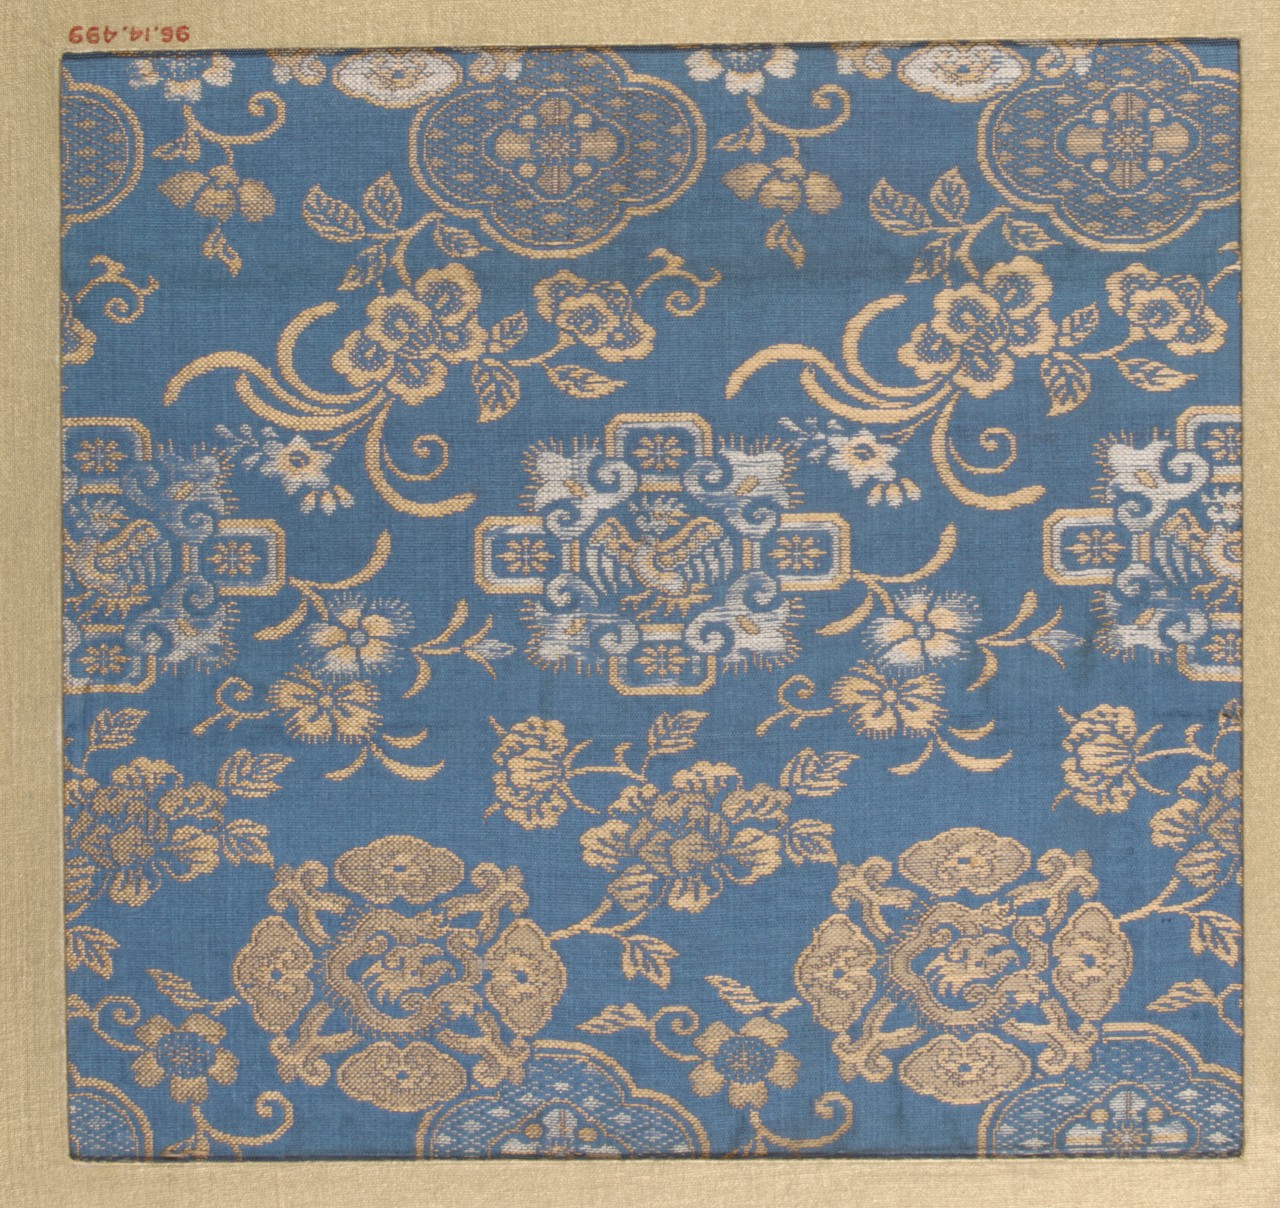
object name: piece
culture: japanese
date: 1701-1900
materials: silk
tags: leaves